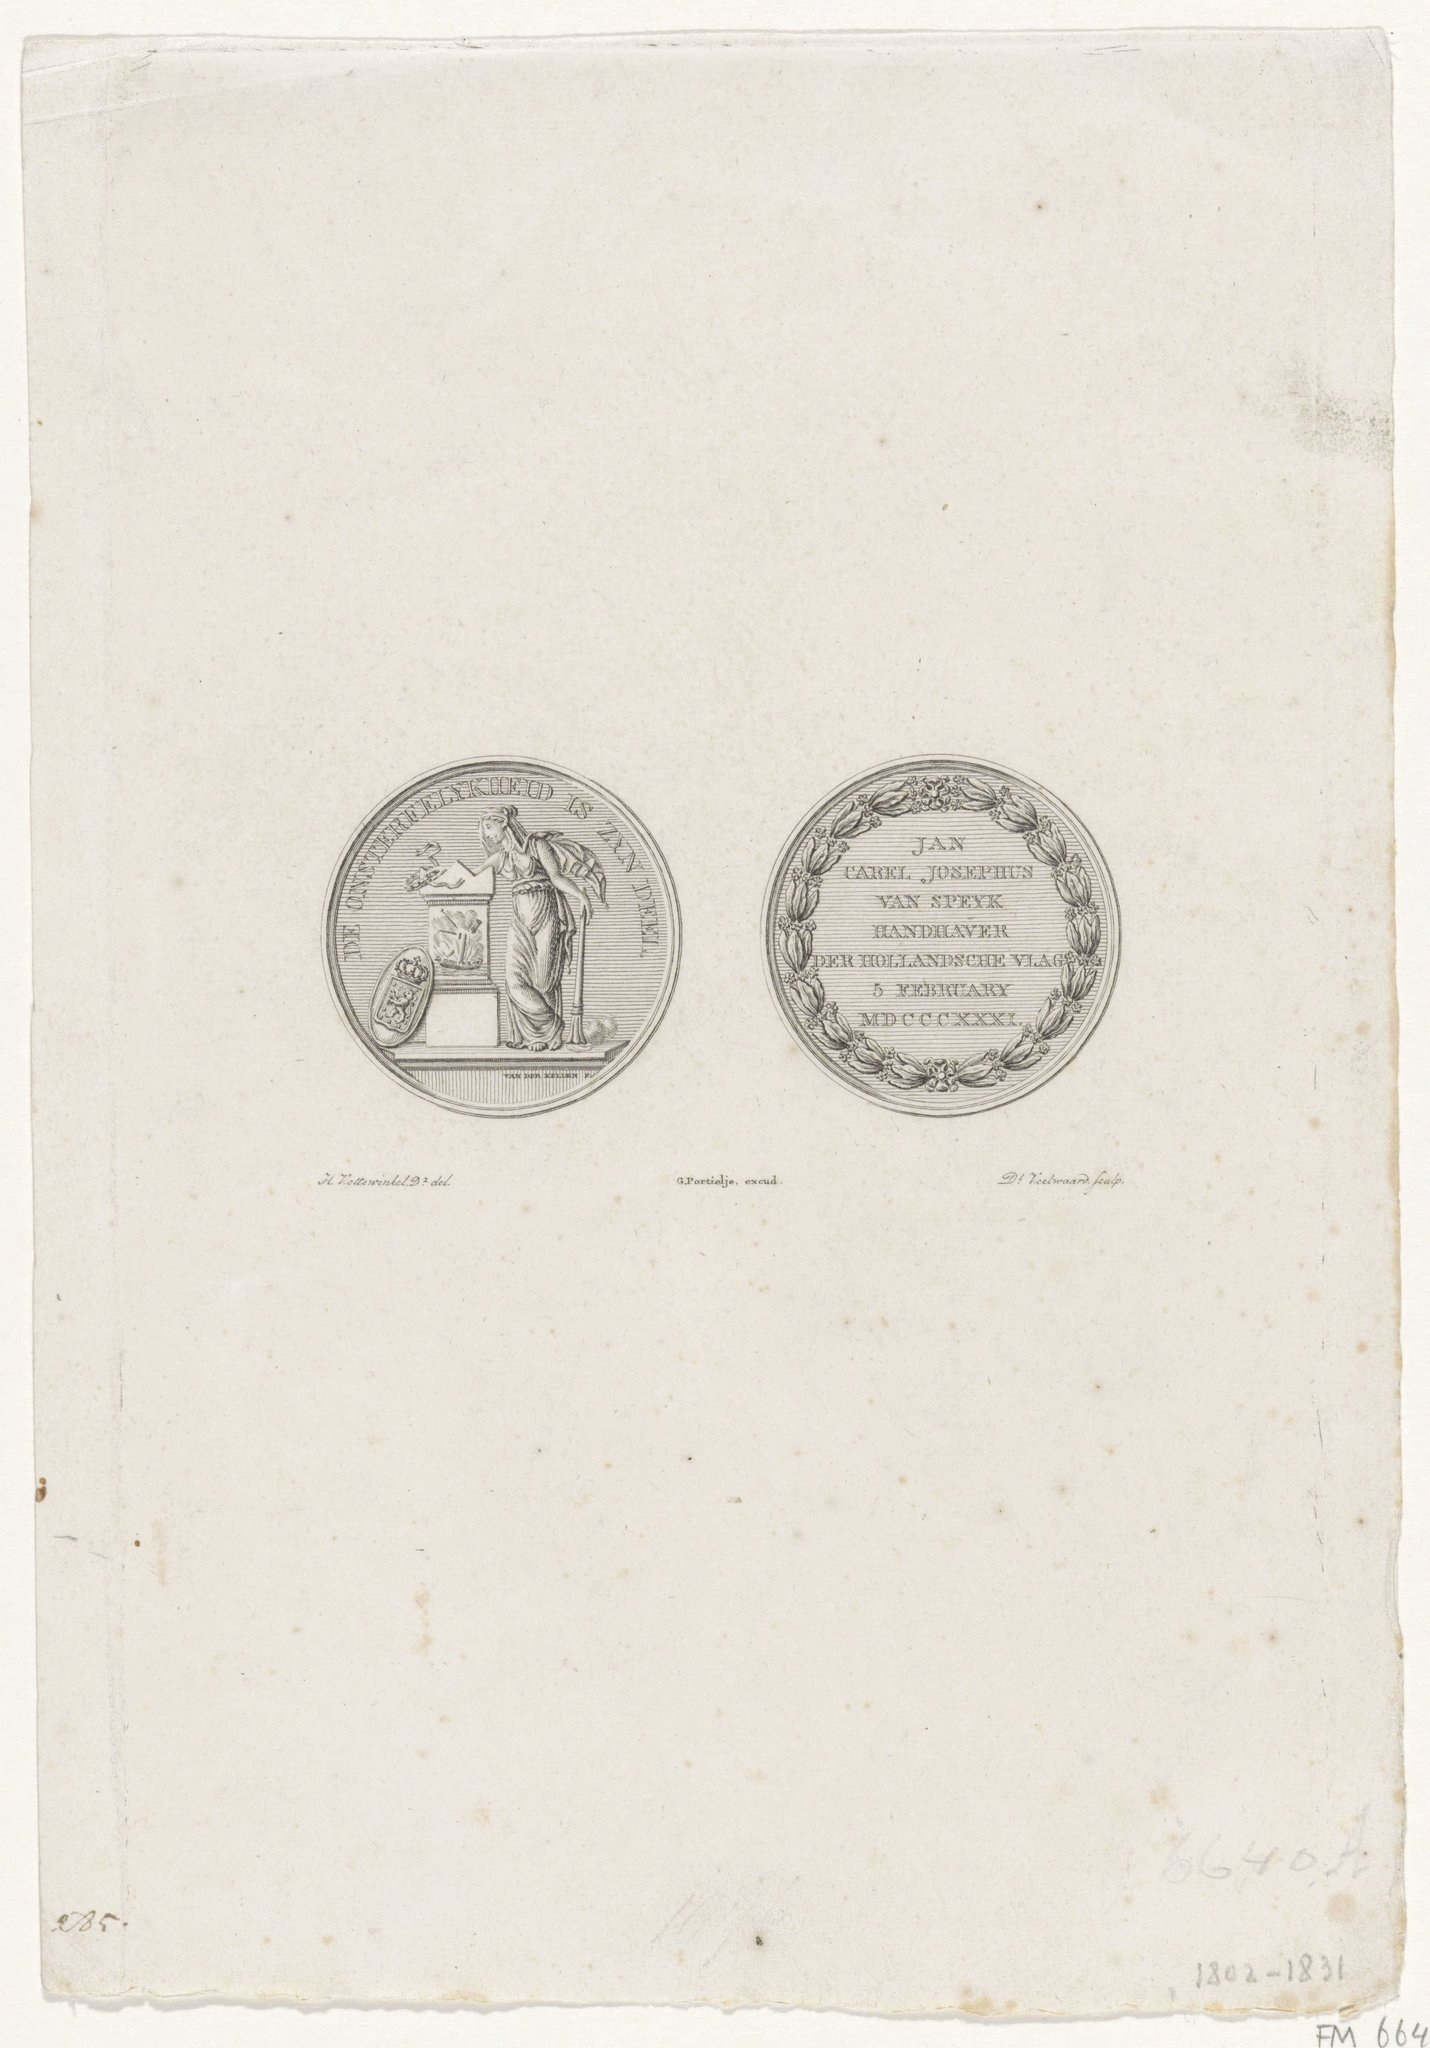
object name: print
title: Penning ter ere van Jan van Speyk, 1831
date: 1831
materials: paper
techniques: engraving, etching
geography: amsterdam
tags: amsterdam, antwerp, jan van speyk, medal (considered as a piece of sculpture, regardless of its specific function)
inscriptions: collector's mark: Lugt 2228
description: Penning ter ere van Jan van Speyk. Op de voorzijde de Nederlandse Maagd met gedoofde fakkel treurend bij een grafsteen waarop een voorstelling van het in de lucht springen van de kanonneerboot van Jan van Speyk op de Schelde voor Antwerpen op 5 februari 1831. Op de keerzijde tekst binnnen een mirtekrans.